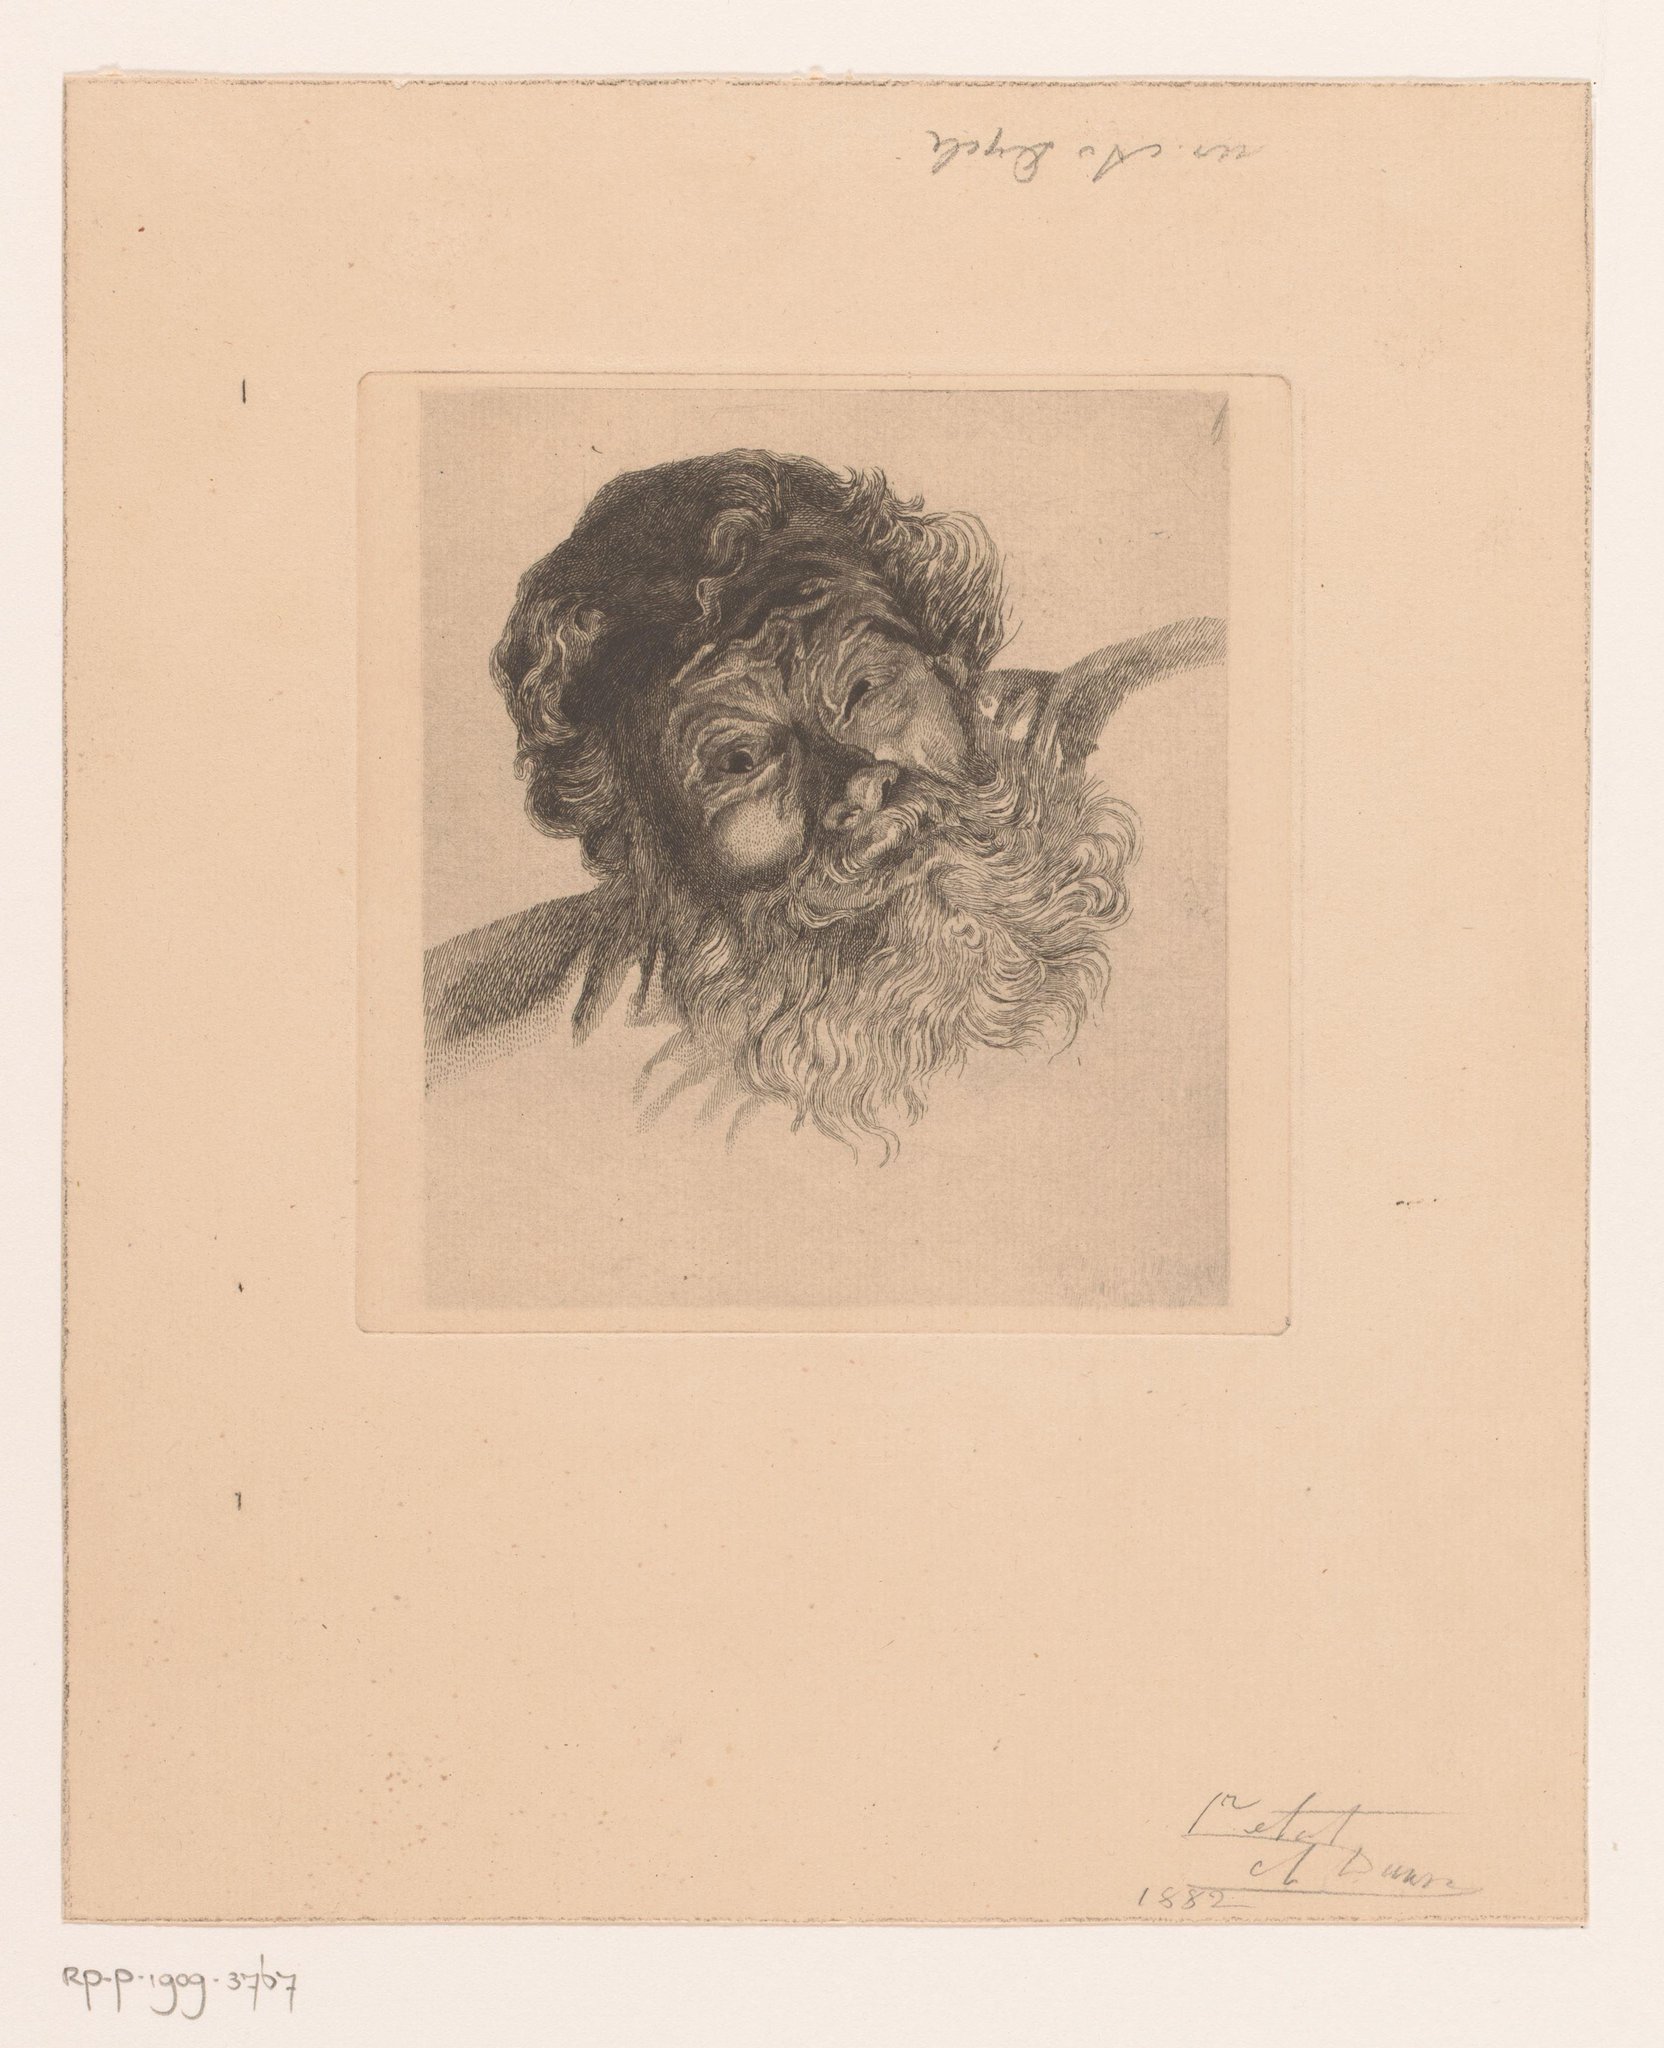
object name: print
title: Silenus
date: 1882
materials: paper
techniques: etching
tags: (story of) silenus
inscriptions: annotation: ‘1er etat’, collector's mark: Lugt 2228